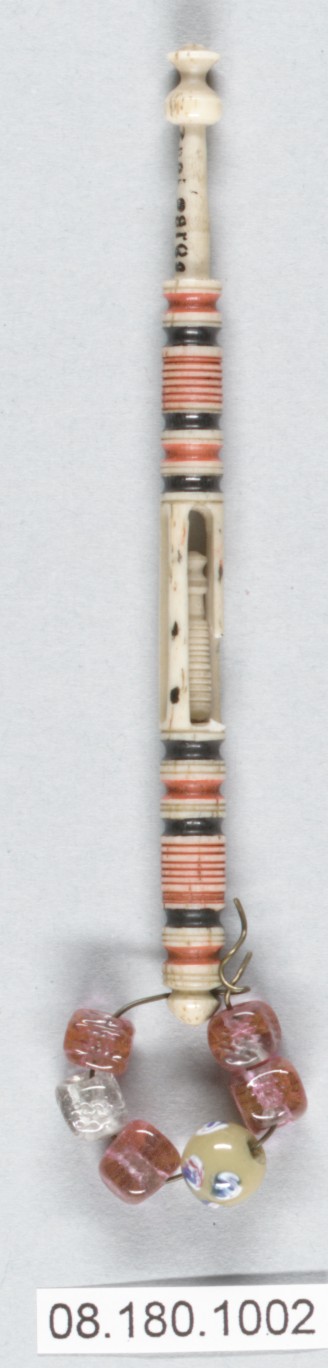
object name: bobbin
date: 1801-1900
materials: bone